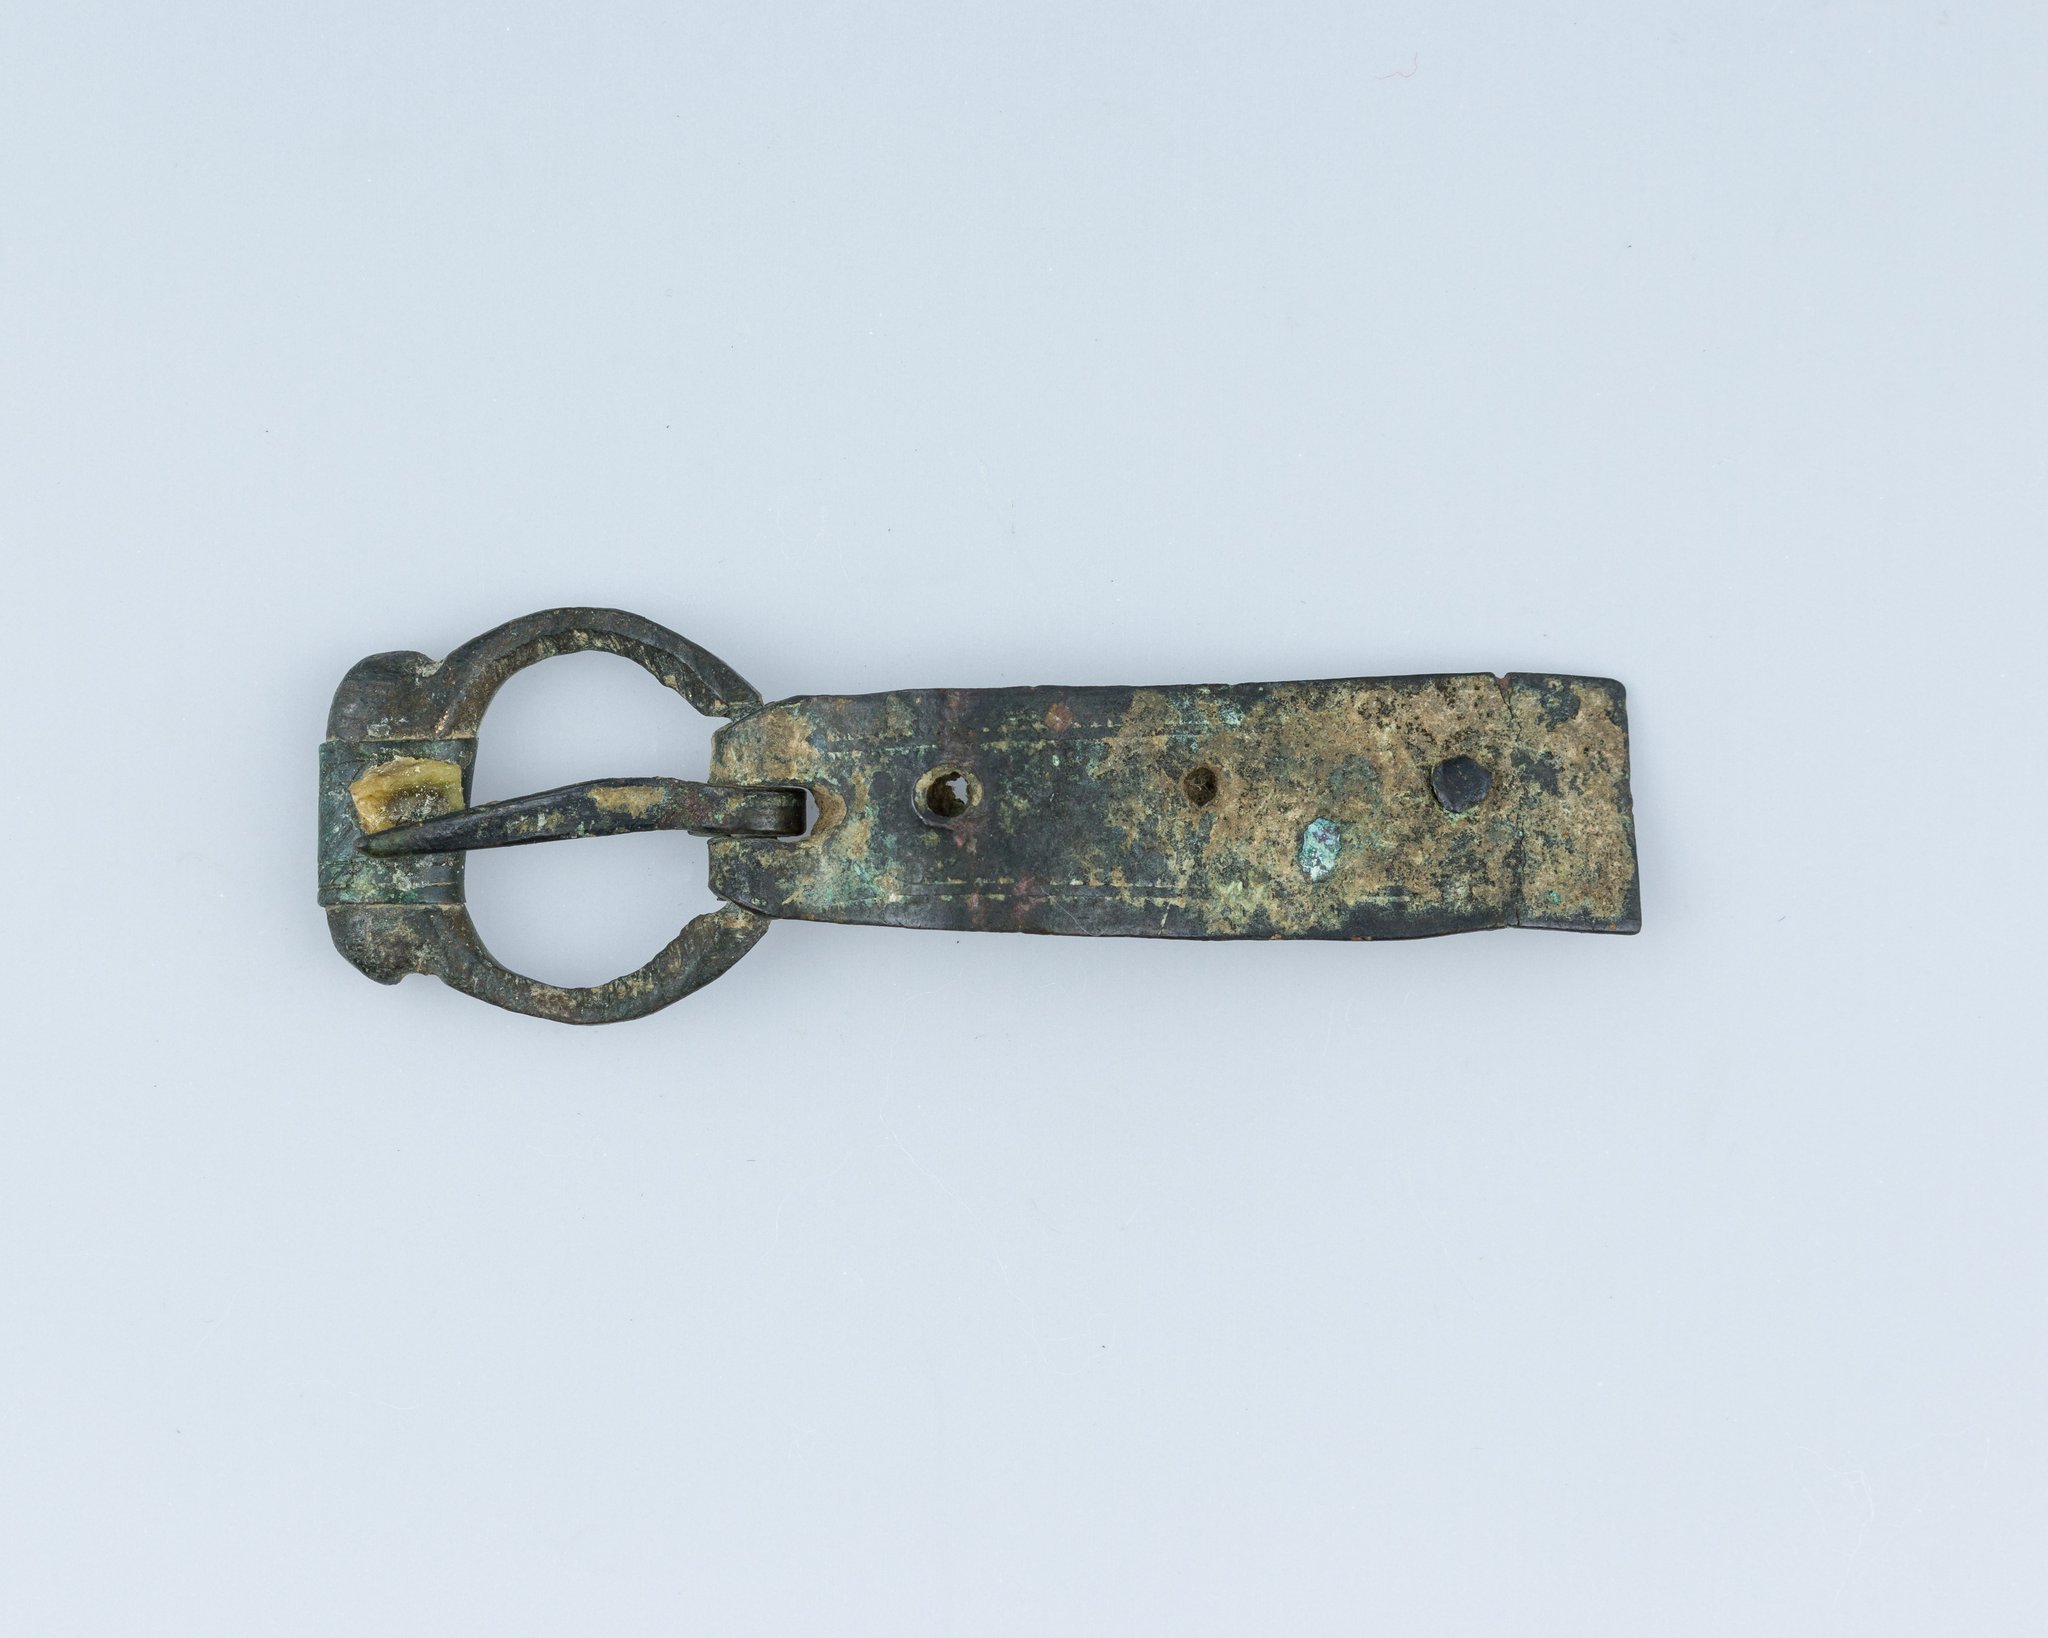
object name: buckle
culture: french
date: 1301-1400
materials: bronze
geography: france